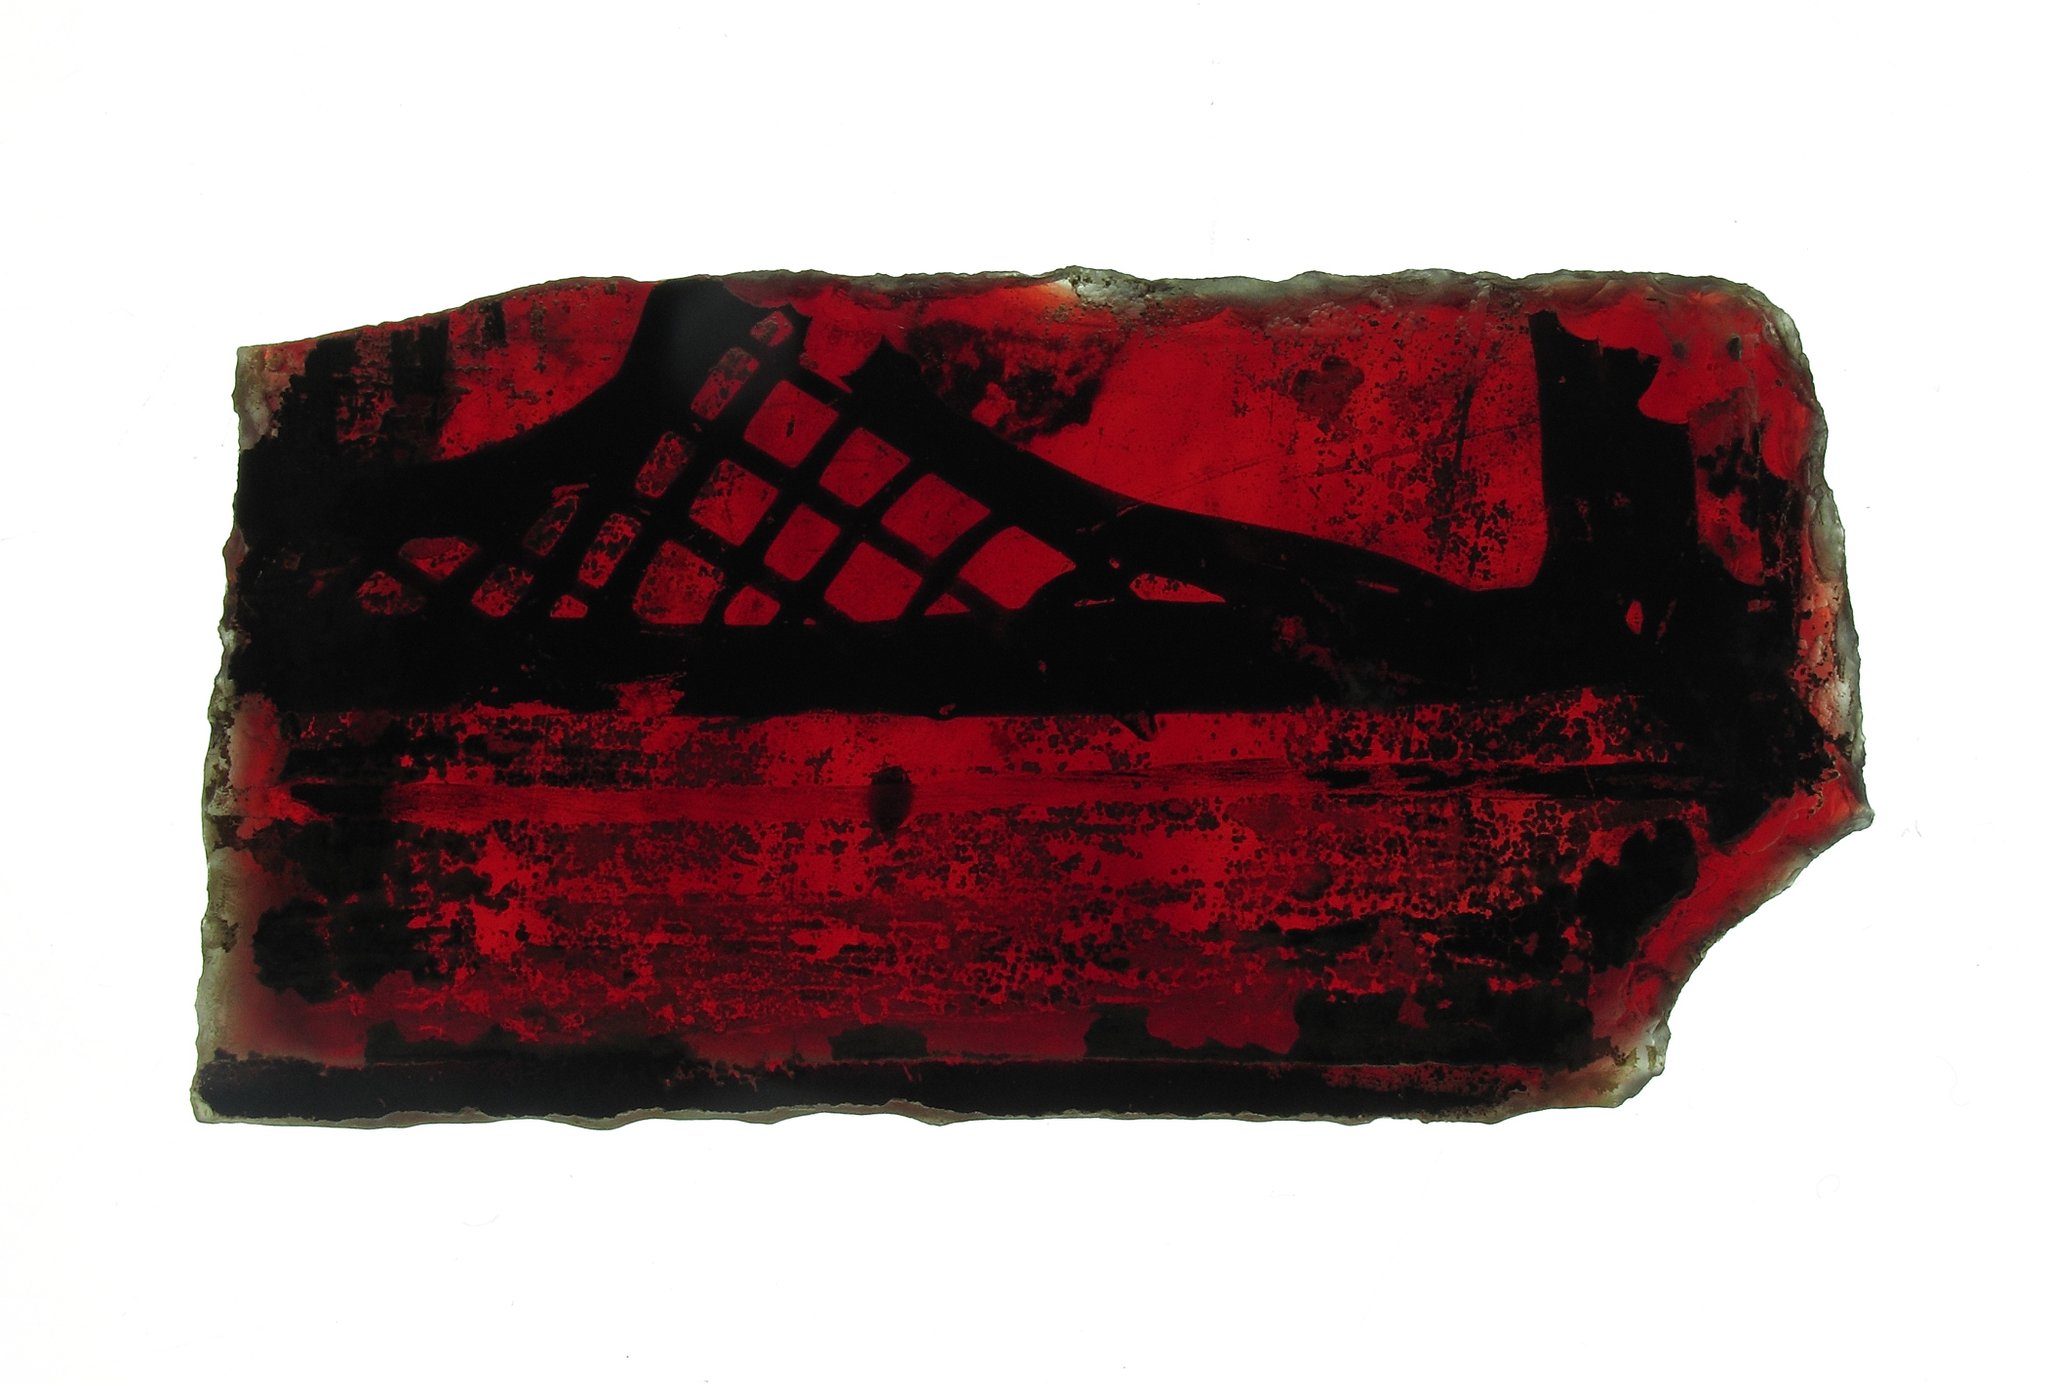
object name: fragment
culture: european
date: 1101-1700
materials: glass, metal, paint